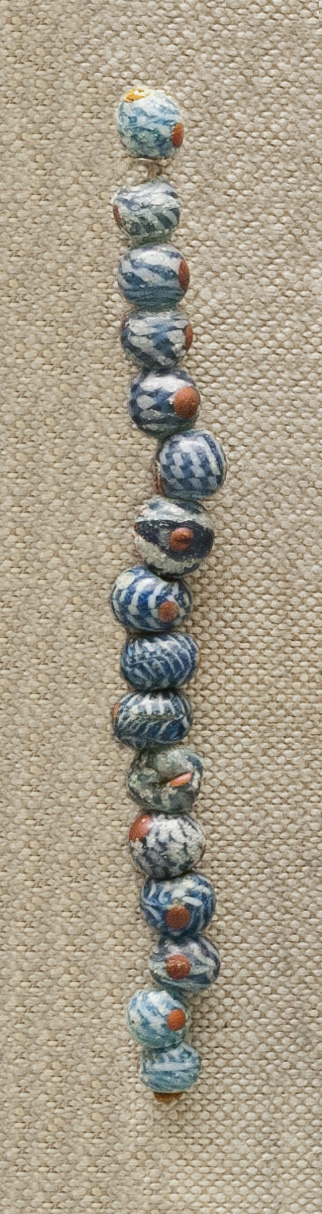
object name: necklace, bead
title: String of 16 Beads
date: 100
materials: glass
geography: egypt